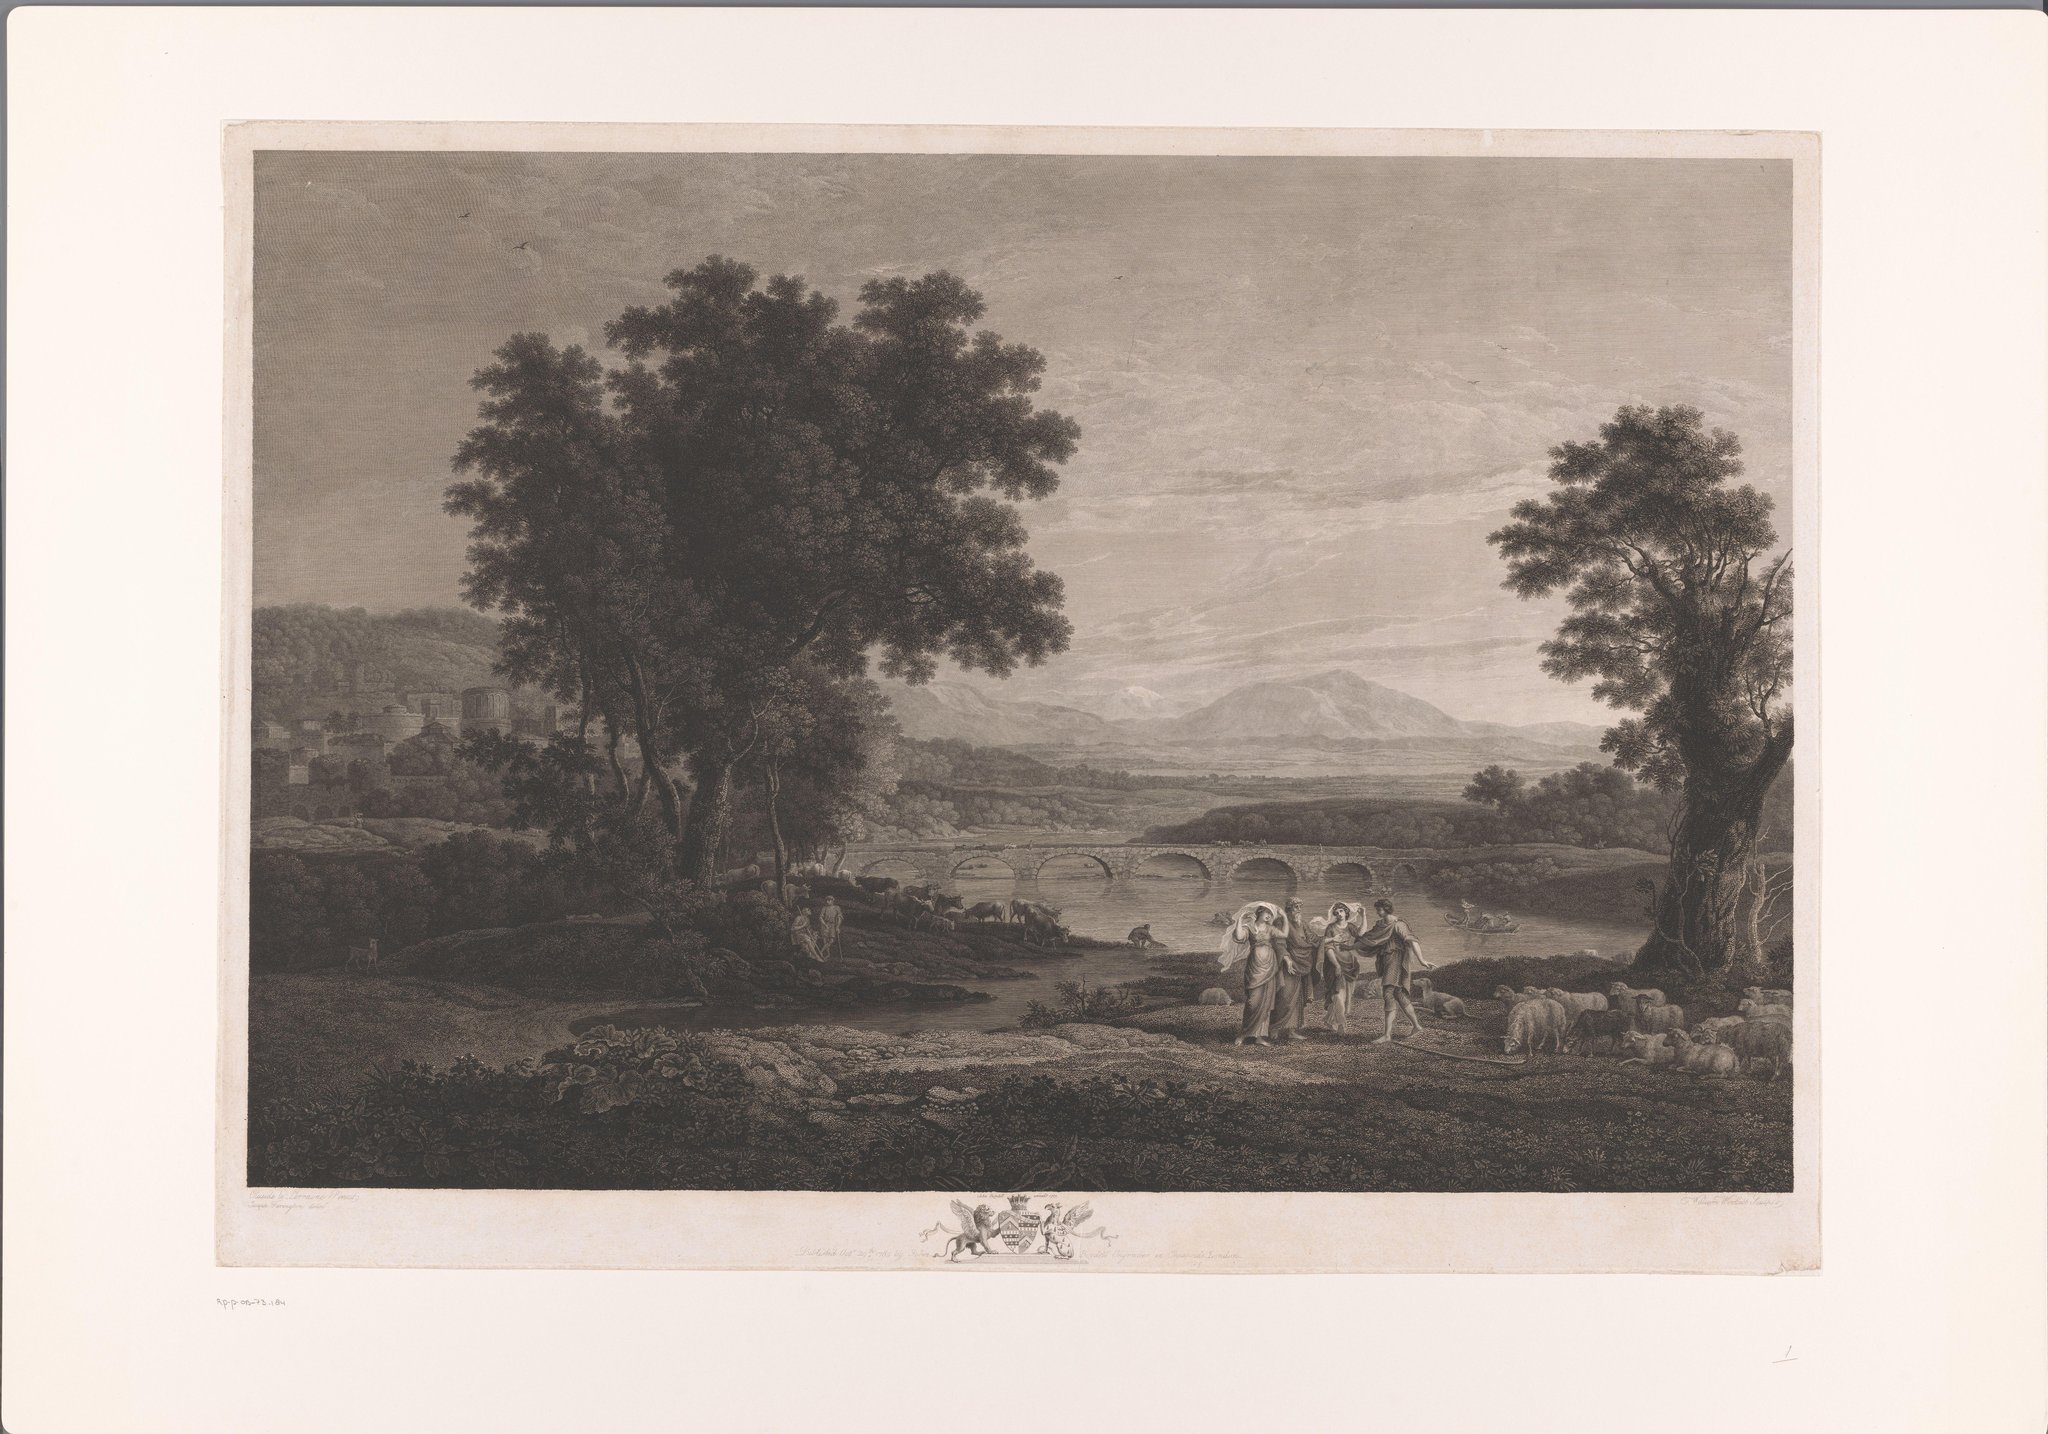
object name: print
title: Groot landschap met Jakob en Laban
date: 1783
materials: paper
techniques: engraving, etching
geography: london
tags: the partnership with laban ~ story of jacob (genesis 30:25-43)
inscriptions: collector's mark: Lugt 12, inscription: ‘f36-’, inscription: ‘f. Spal.on. [?]’